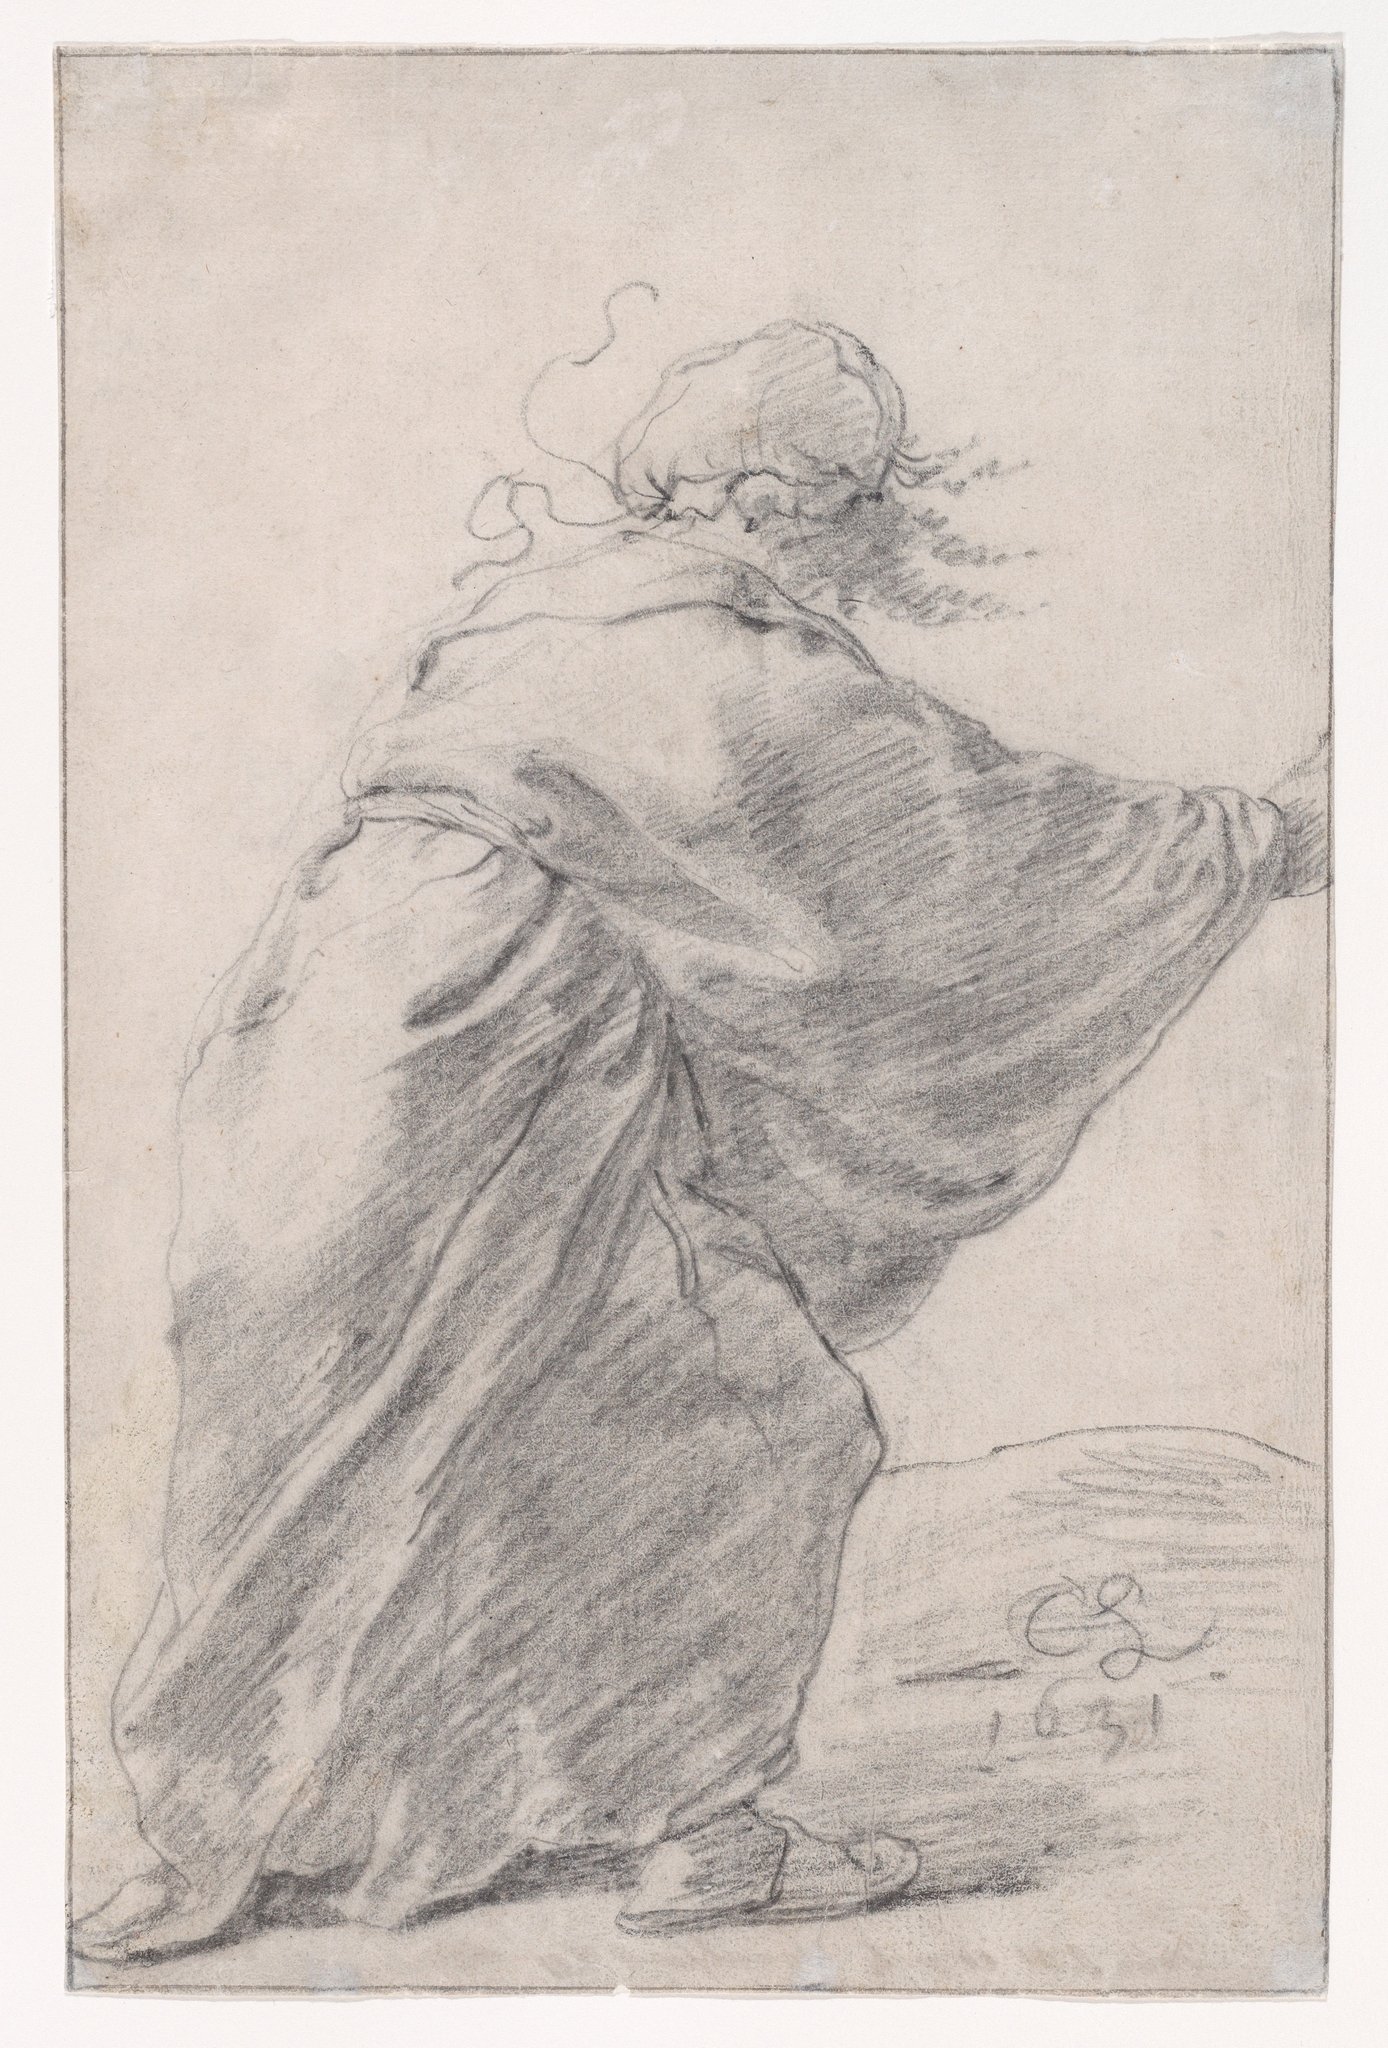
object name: drawing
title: A wild-haired, robed woman rushing to the right, seen from behind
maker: cornelis saftleven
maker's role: artist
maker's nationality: dutch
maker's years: 1607-1681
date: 1631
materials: chalk